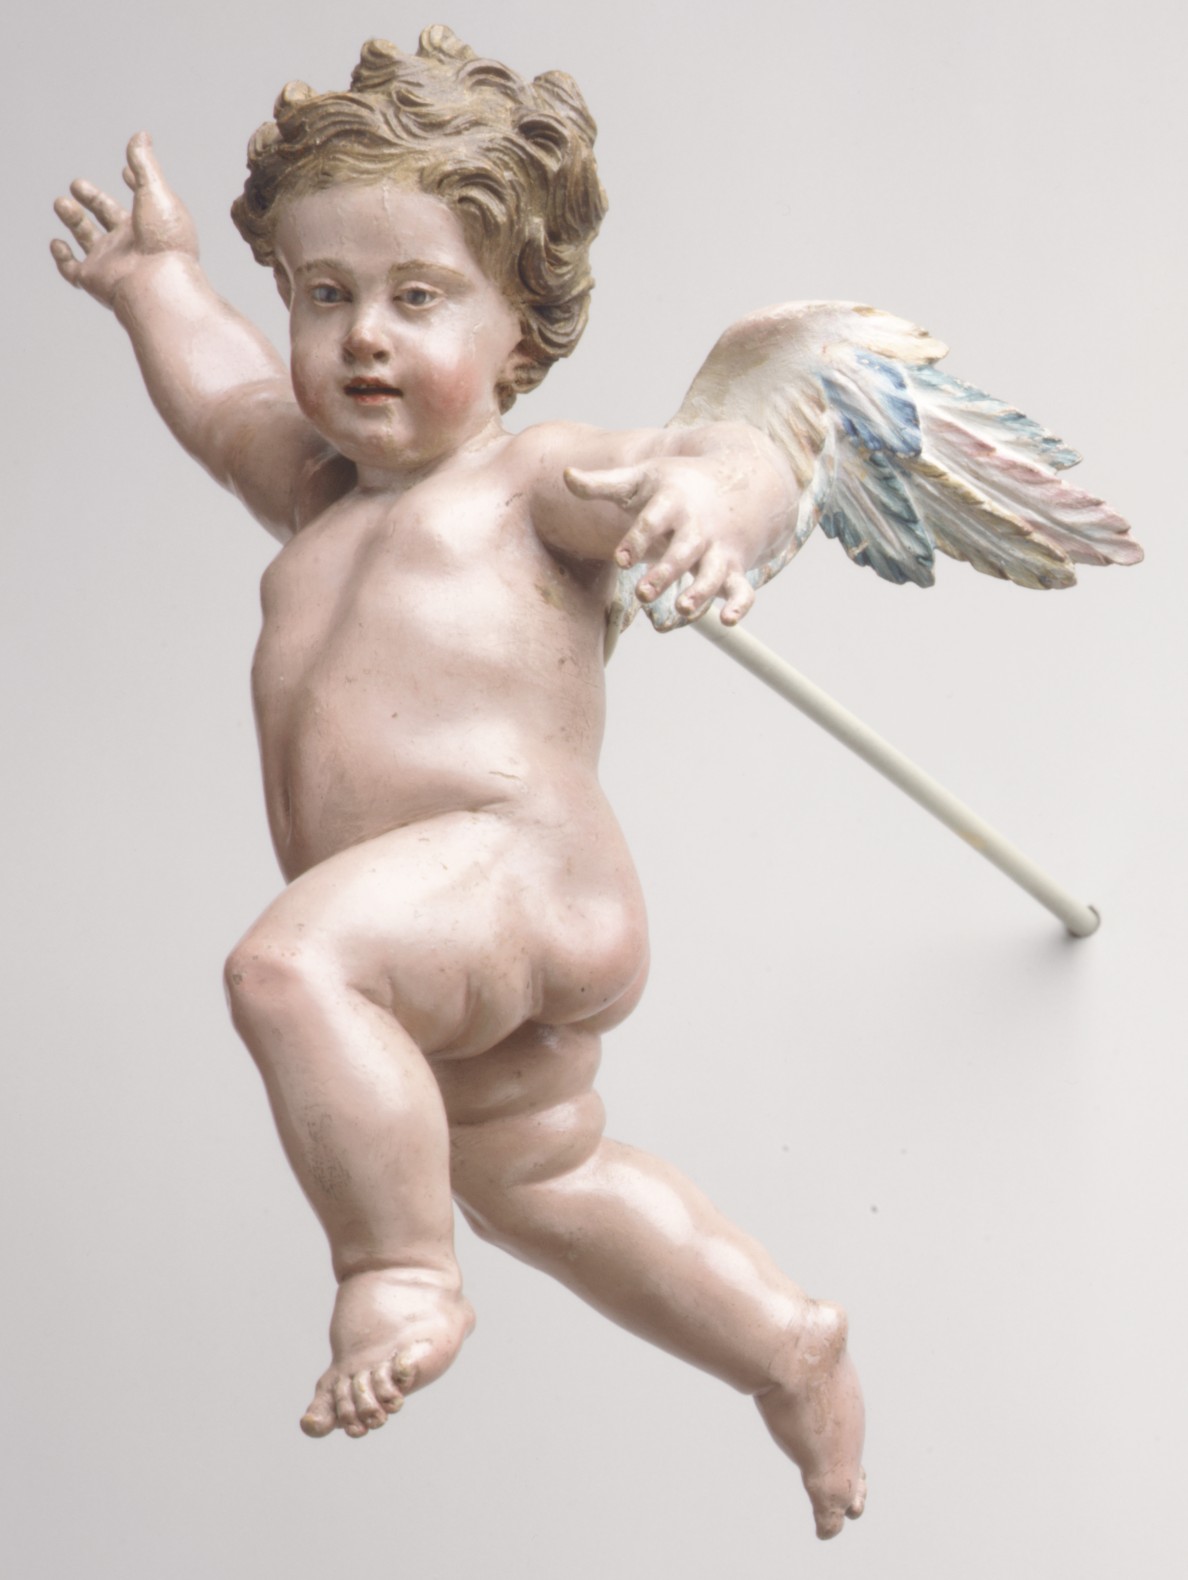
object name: crèche figure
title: Cherub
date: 1751-1800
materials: wood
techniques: polychrome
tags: angels